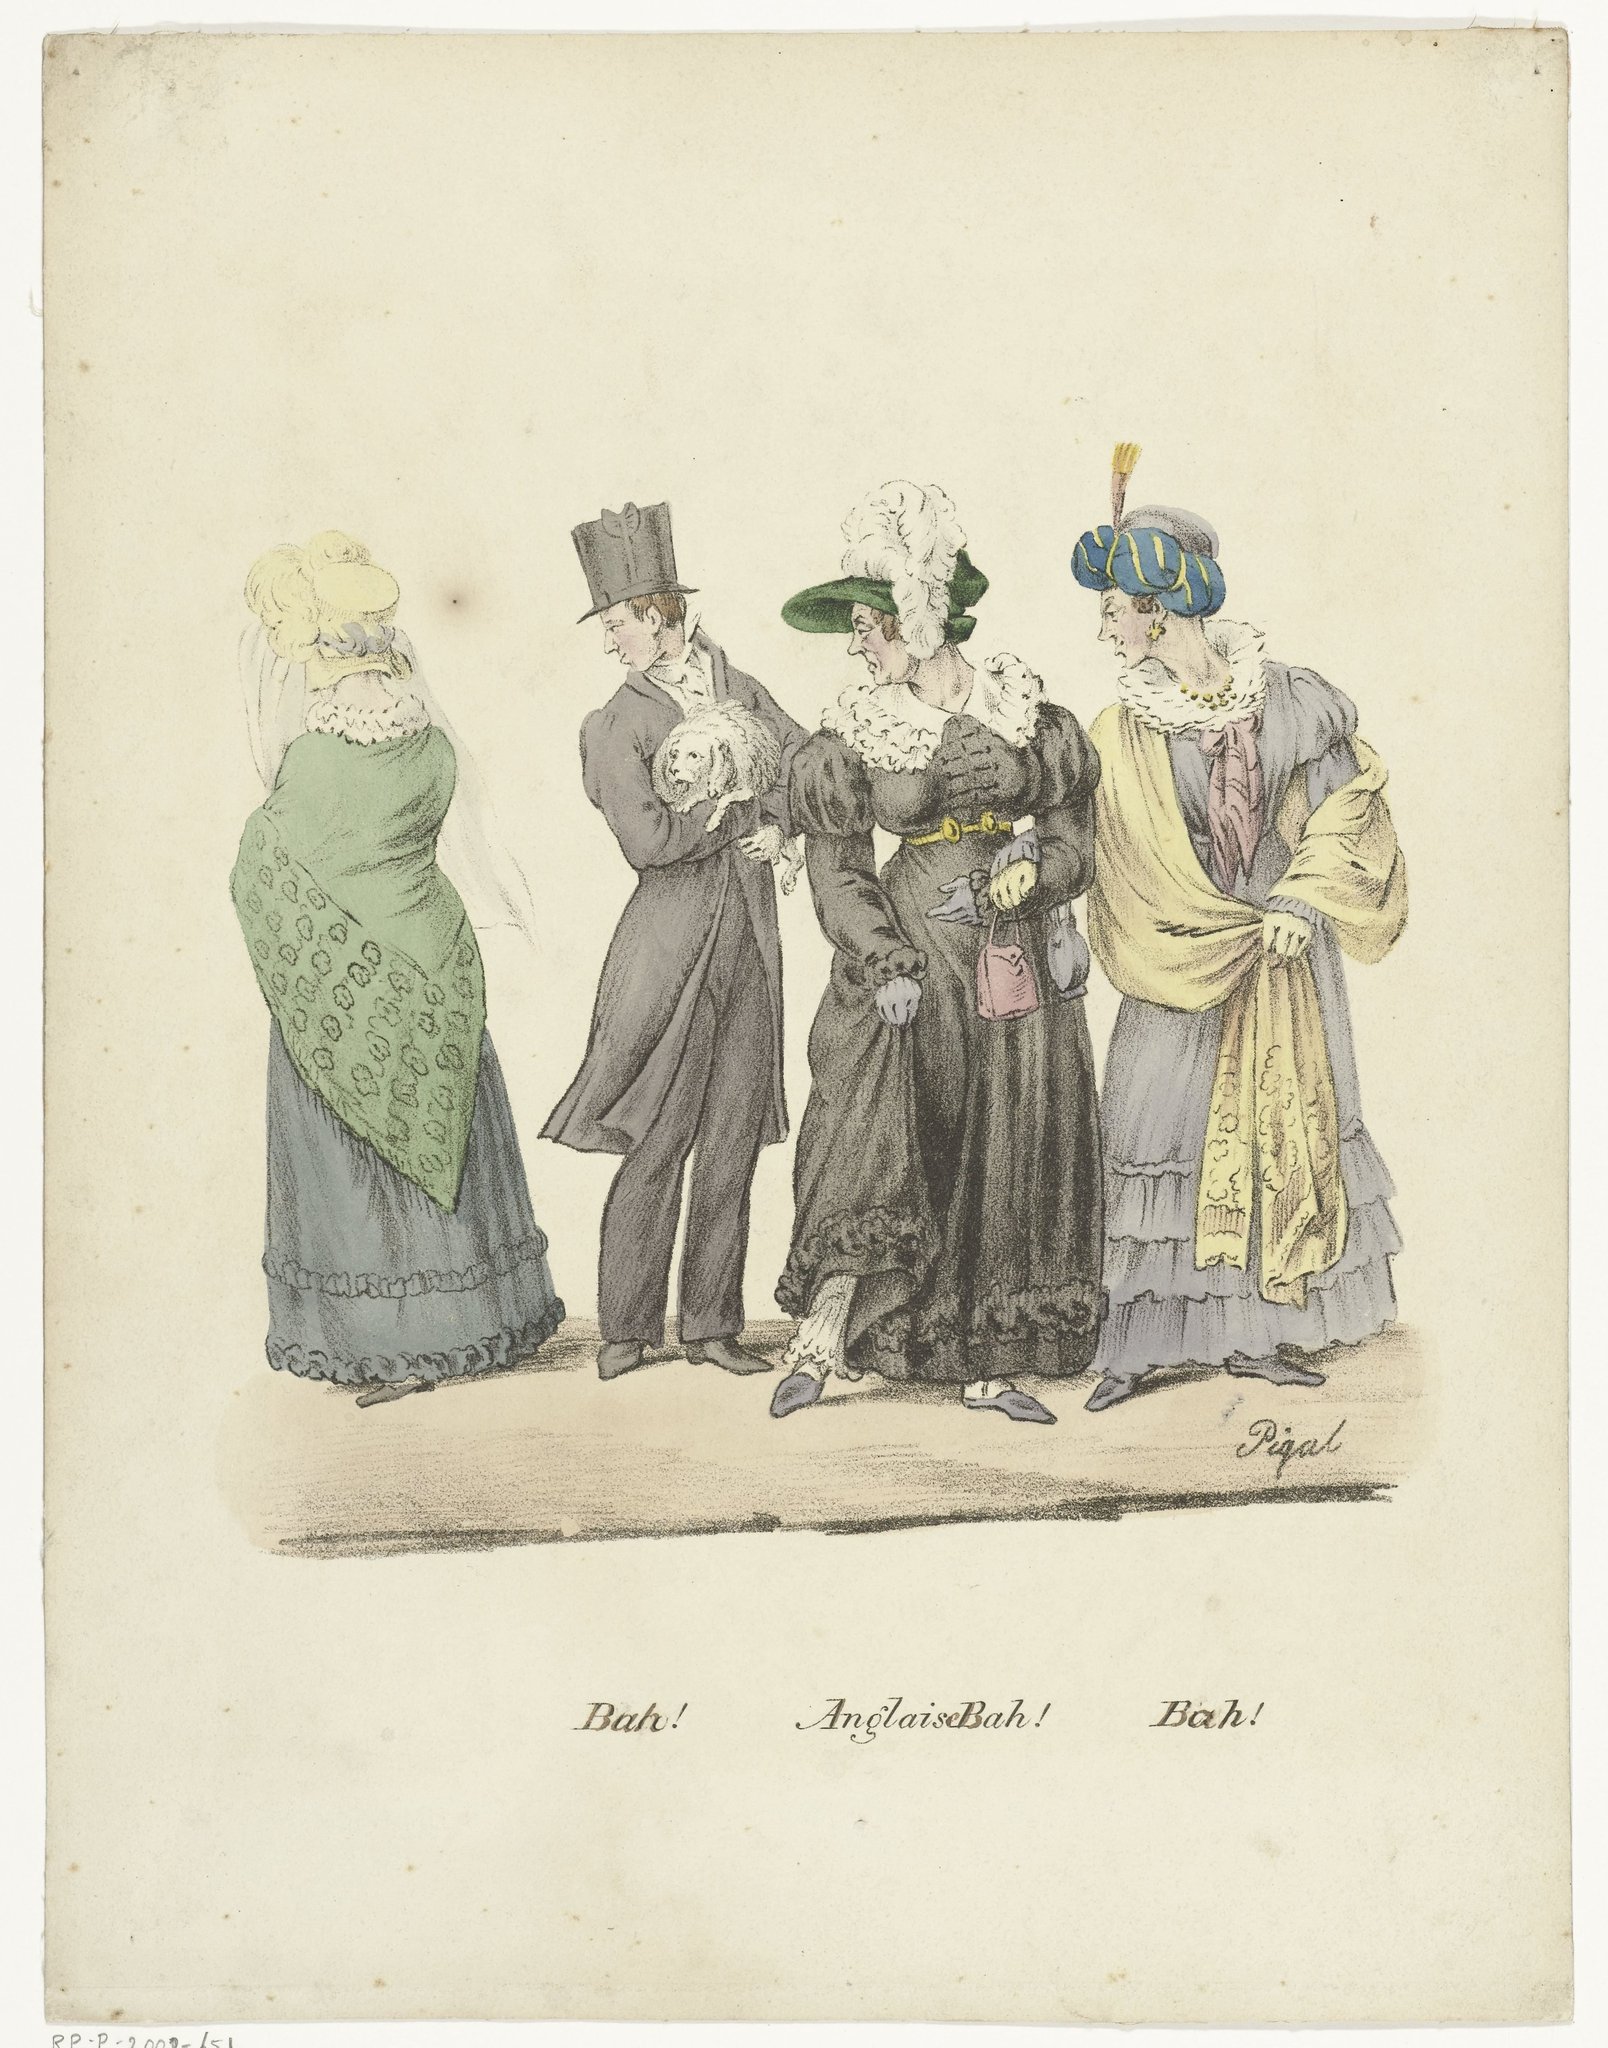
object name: print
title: Bah! Anglaise Bah! Bah!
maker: edme jean pigal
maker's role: print maker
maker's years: 1798-1872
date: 1808-1872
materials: linen, paper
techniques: hand coloring, lithograph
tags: europeans: englishmen (+ women), adult woman (+ three persons), fashion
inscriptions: collector's mark: Lugt 2228